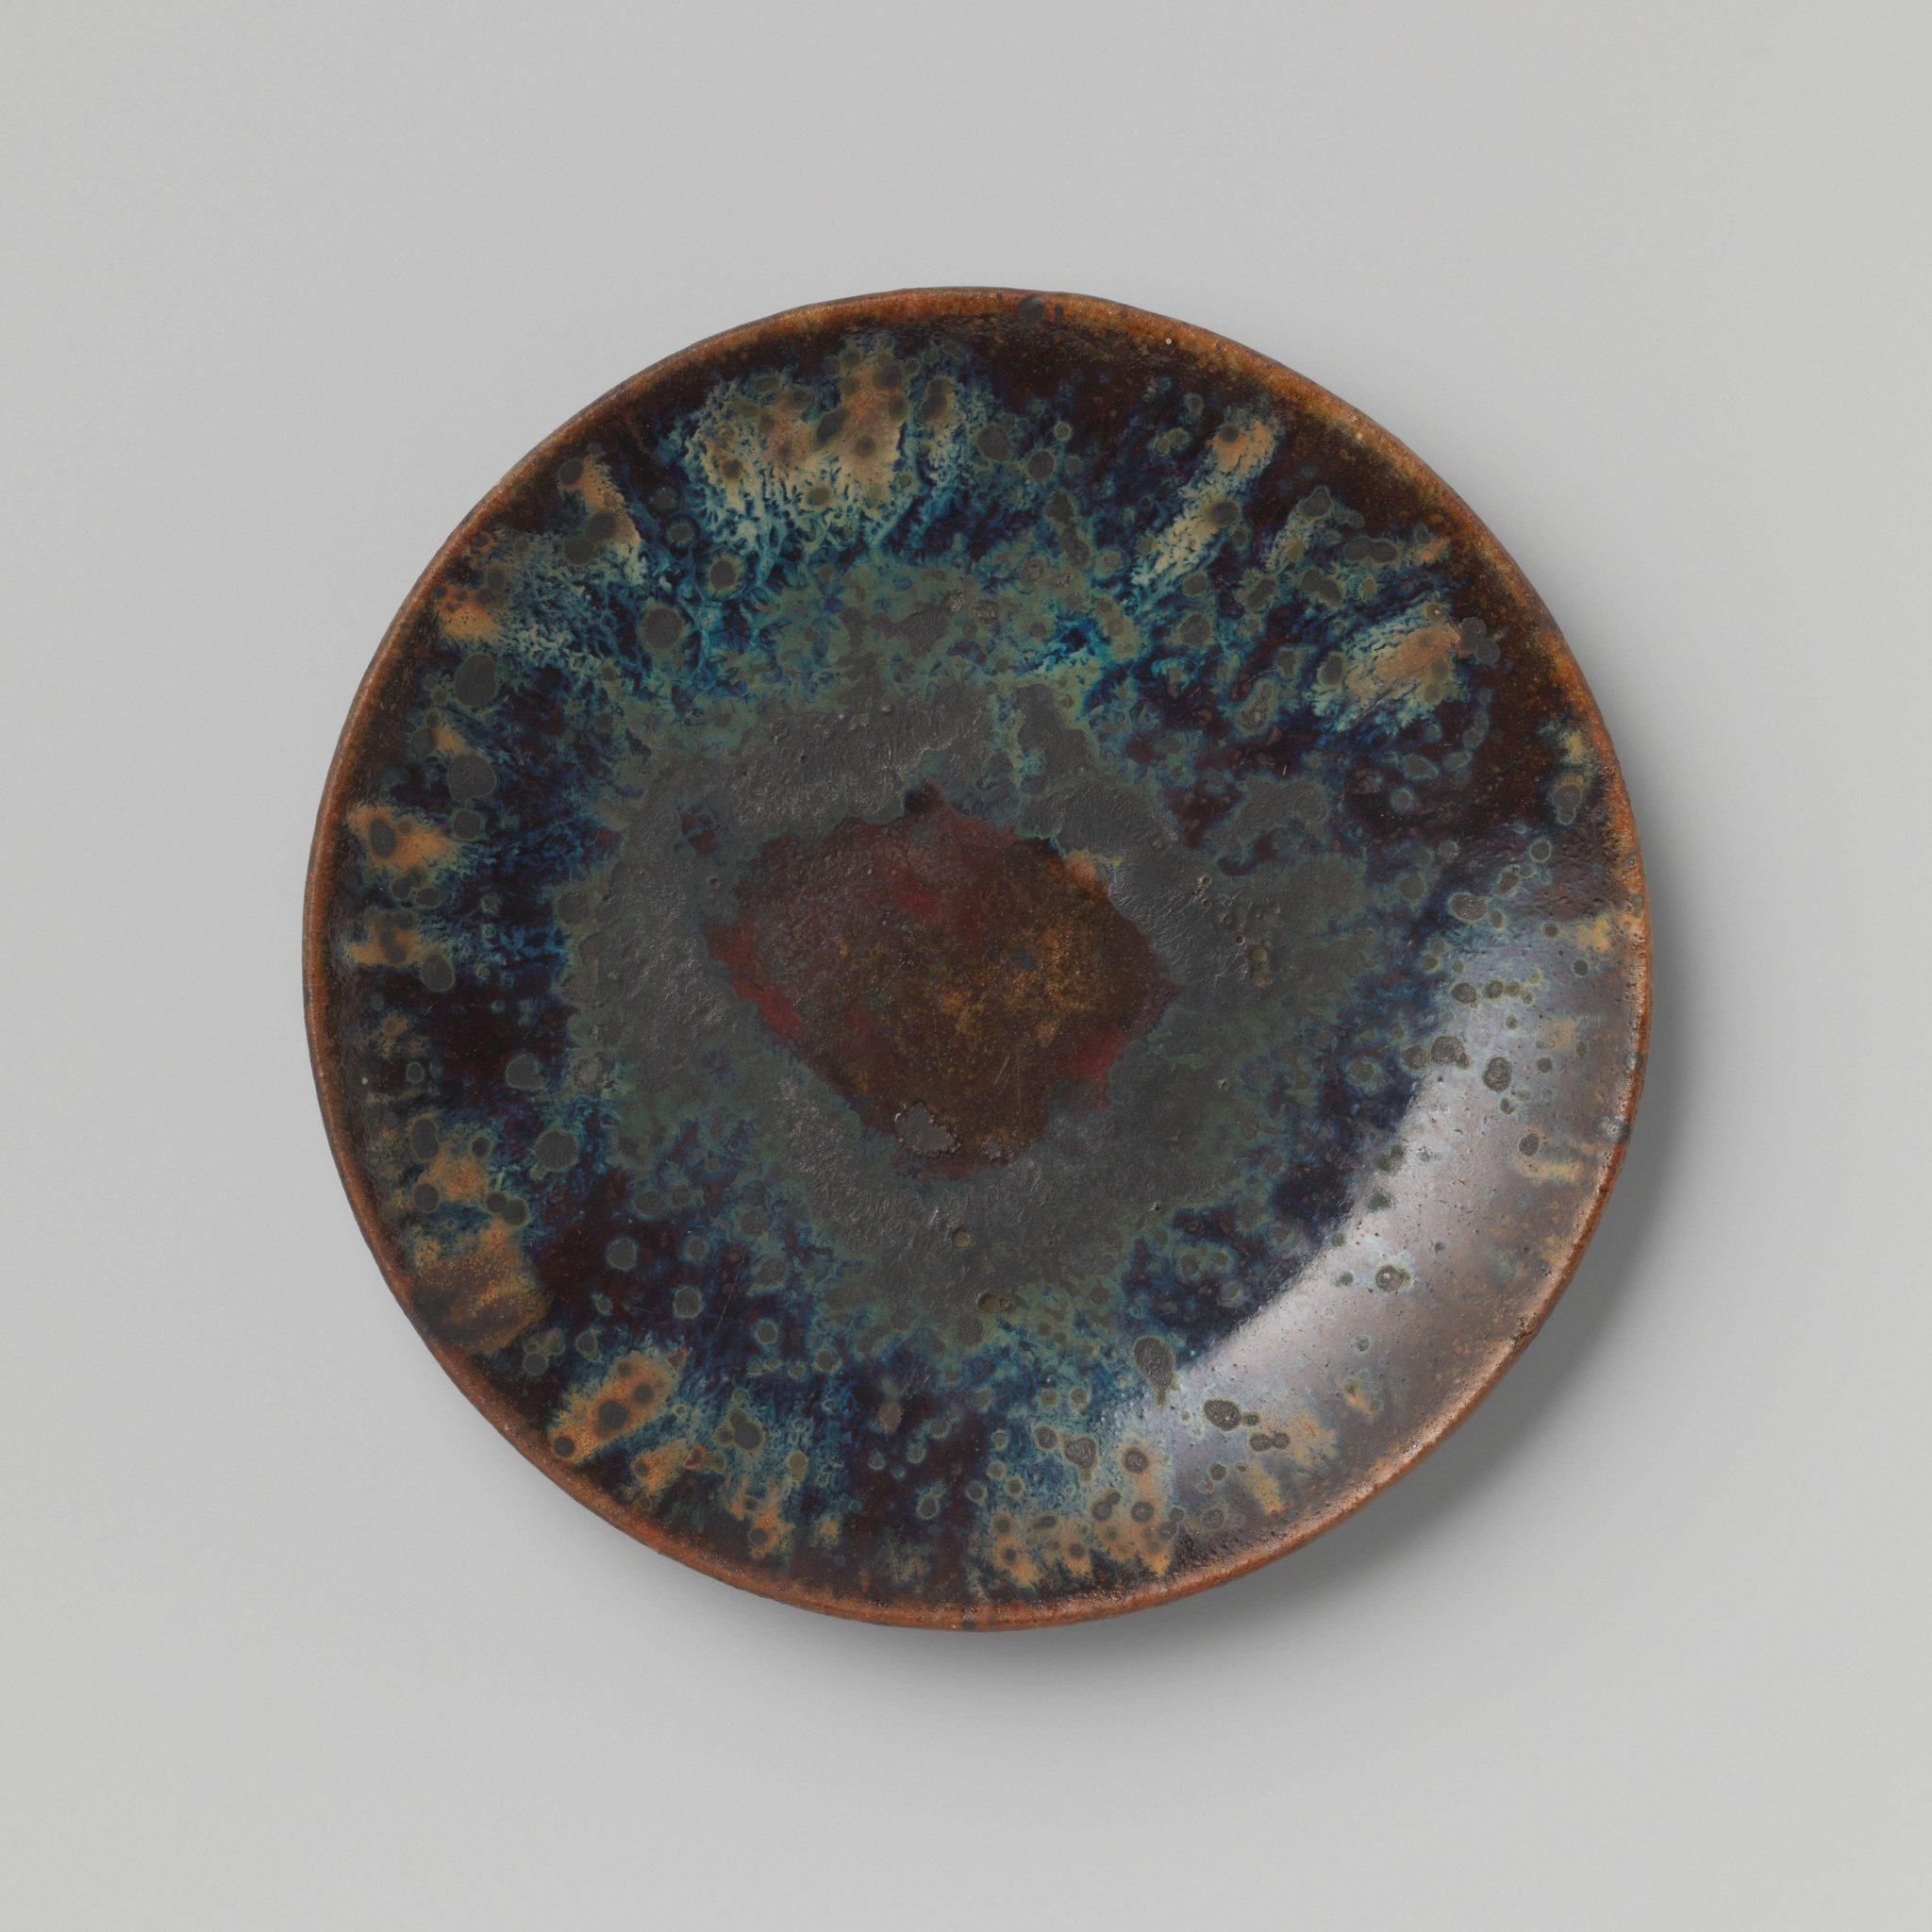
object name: platter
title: Set of Two Cups and Saucers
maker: pierre adrien dalpayrat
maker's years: 1844-1910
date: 1900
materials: earthenware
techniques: vitrification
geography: bourg-la-reine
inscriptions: mark: ‘DALPAYRAT’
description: Schotel van aardewerk met een gevlamde roodbruine en gele glazuur.